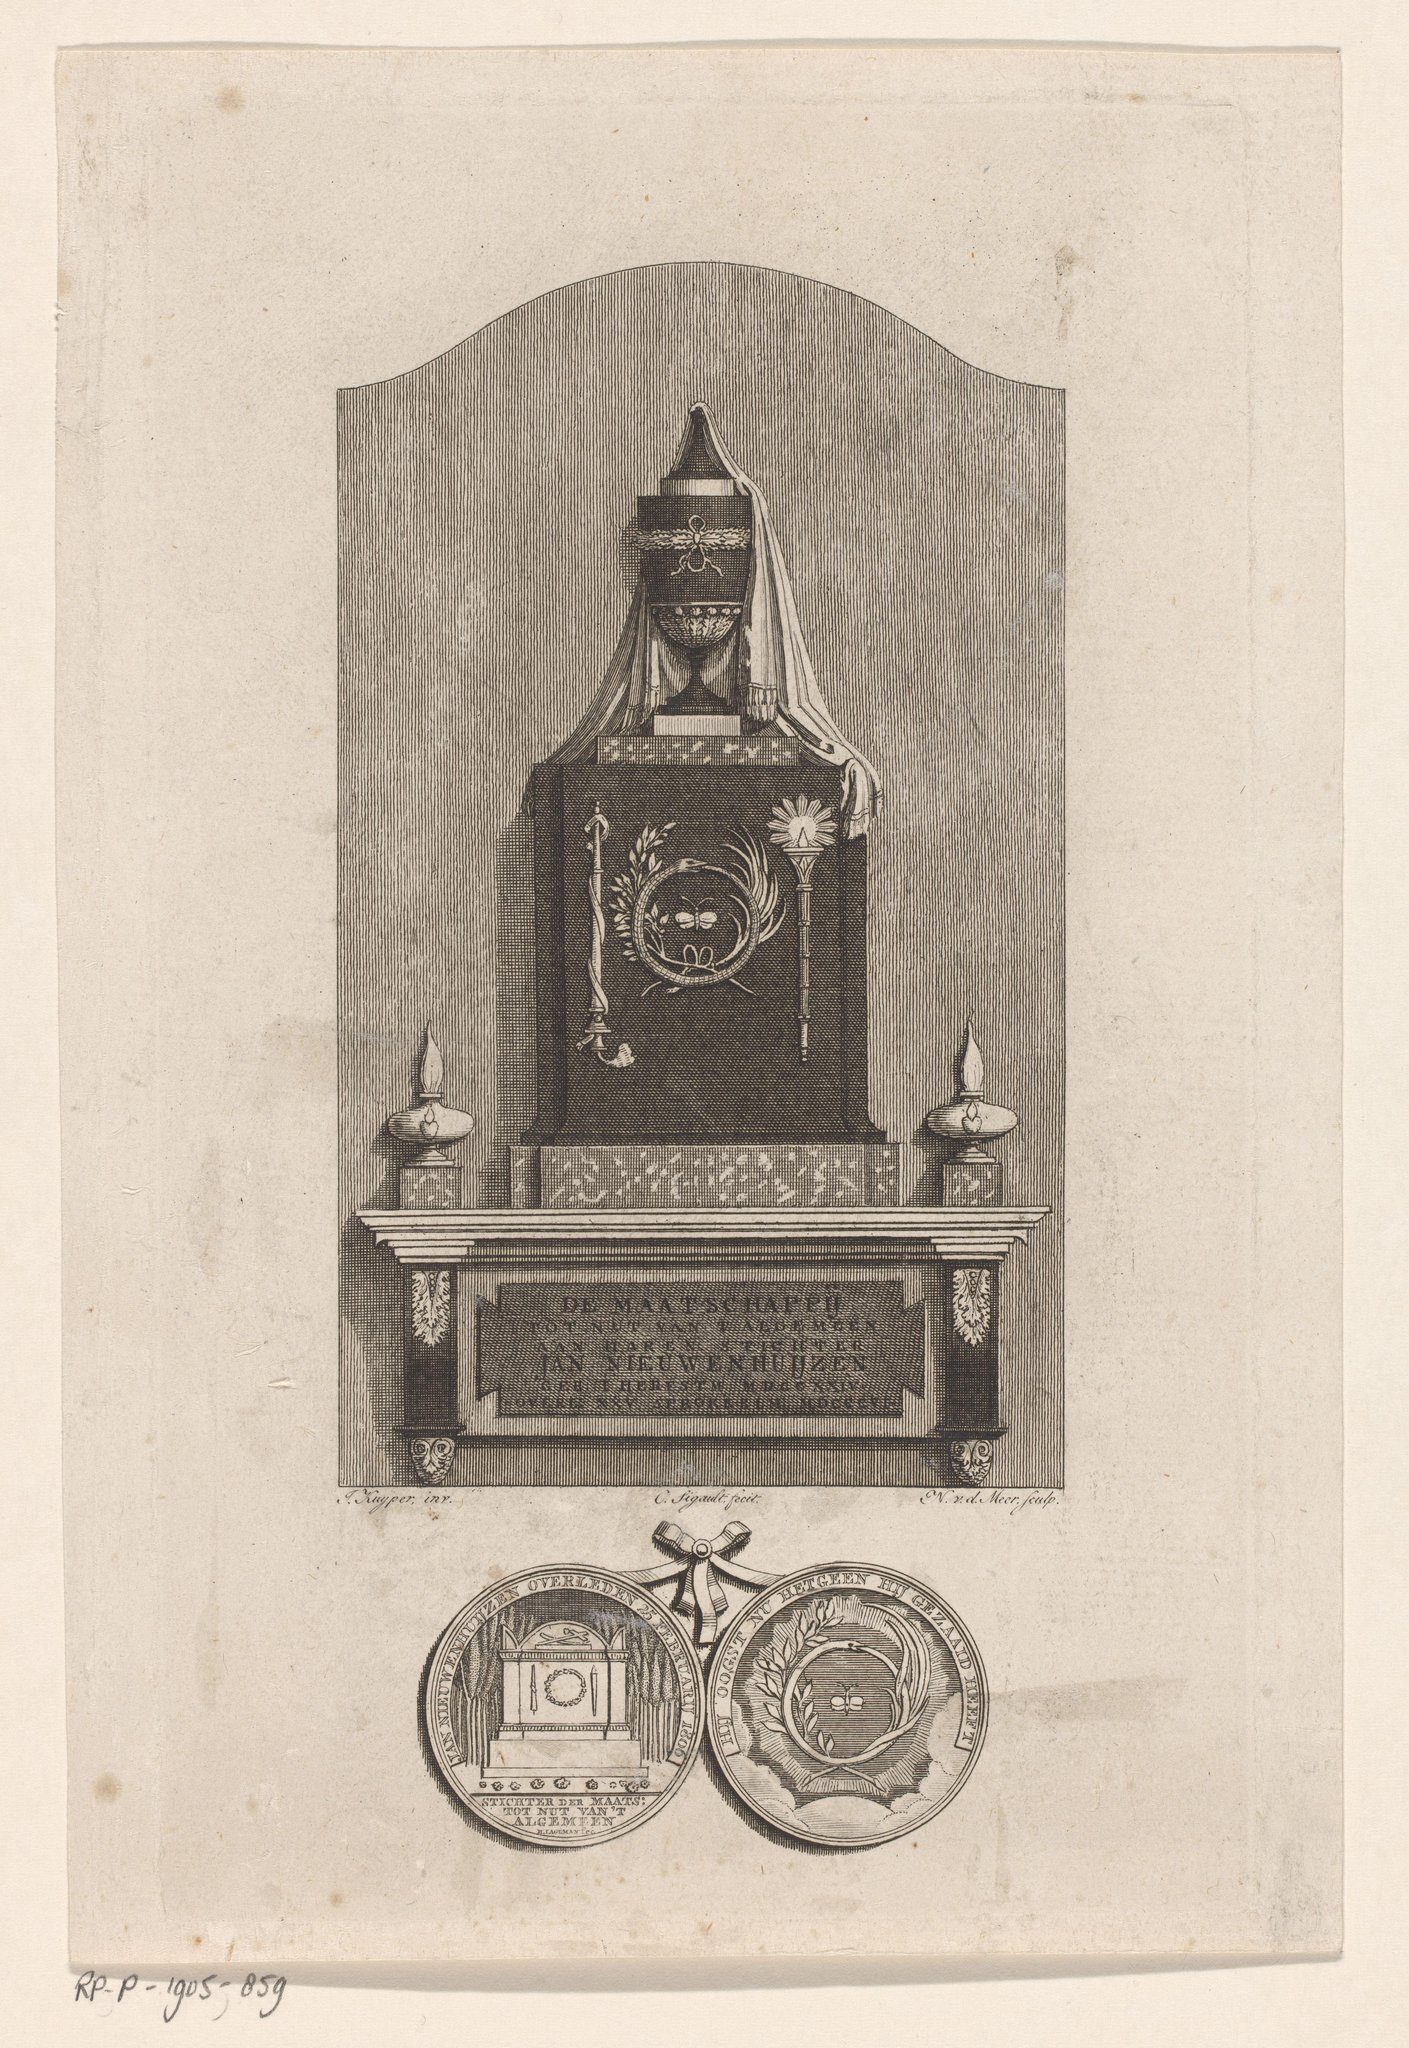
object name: print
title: Grafmonument voor Jan Nieuwenhuyzen in de Grote Kerk te Monnickendam en penning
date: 1806-1808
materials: paper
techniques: etching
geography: amsterdam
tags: haarlem, amsterdam, jan nieuwenhuyzen, memorial medal, grave, tomb and other grave-forms and grave-markers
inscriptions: collector's mark: Lugt 2228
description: Gedenkteken voor Jan Nieuwenhuyzen door De Maatschappij tot Nut van t' Algemeen opgericht. In het midden een omgekeerde fakkel, een slang die in zijn eigen staart bijt als eeuwigheidsymbool en een brandende fakkel. Onderaan in de marge de voor- en achterzijde van een gedenkpenning, die ter gelegenheid van de dood van Nieuwenhuyzen werd vervaardigd.